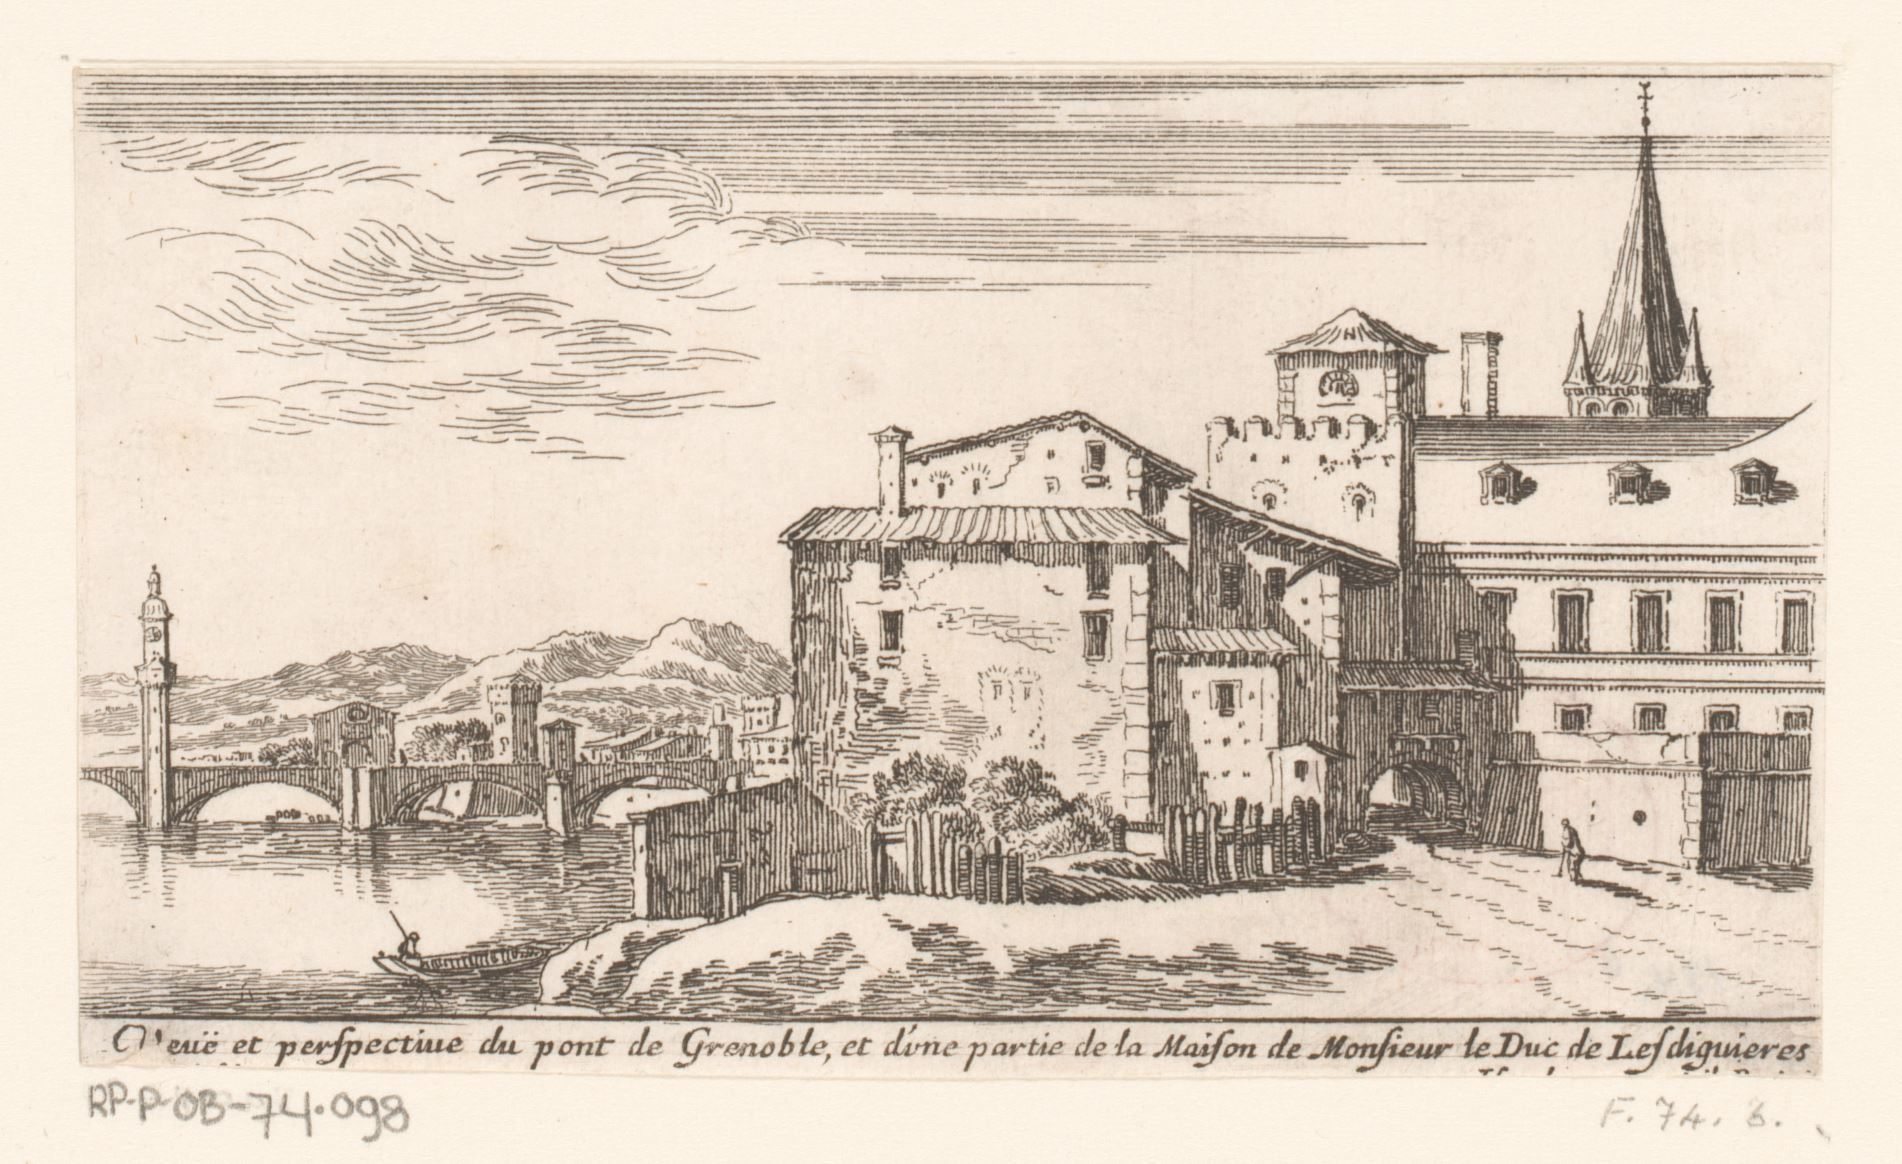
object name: print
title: Landschappen in de buurt van Lyon en Grenoble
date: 1631-1661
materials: paper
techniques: etching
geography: france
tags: bridge, city-view, and landscape with man-made constructions (+ city(-scape) with figures, staffage)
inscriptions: collector's mark: Lugt 240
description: Prent maakt deel uit van een ongenummerde serie van zeven prenten.